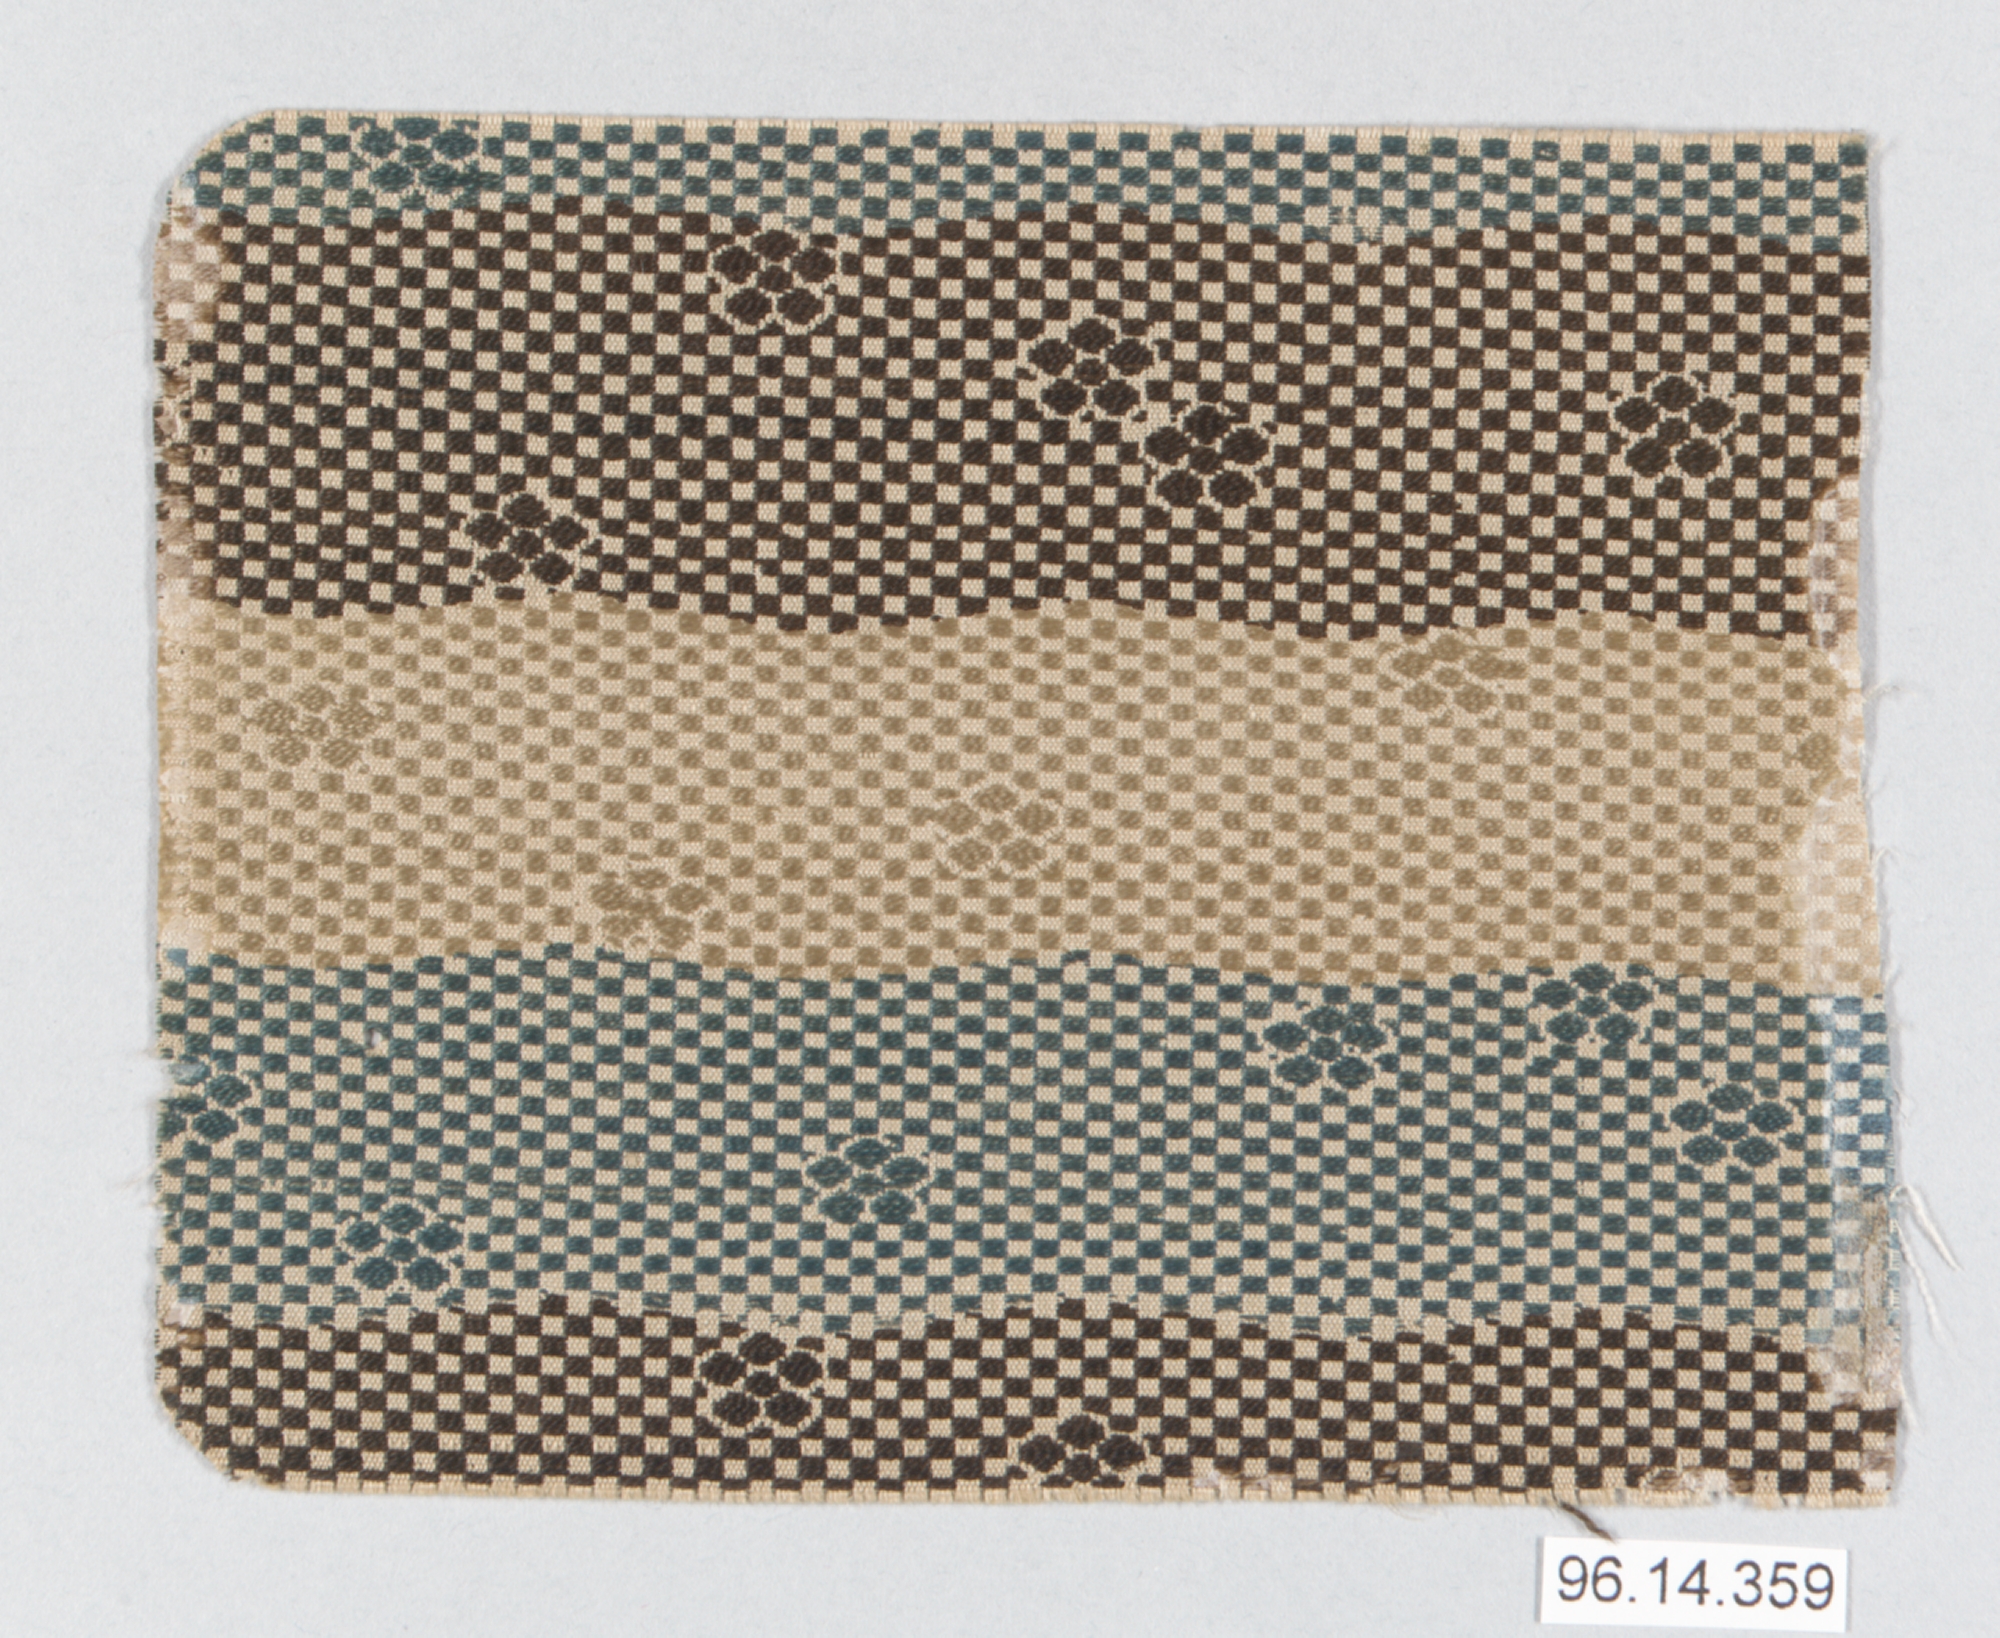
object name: piece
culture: japanese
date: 1601-1700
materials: silk